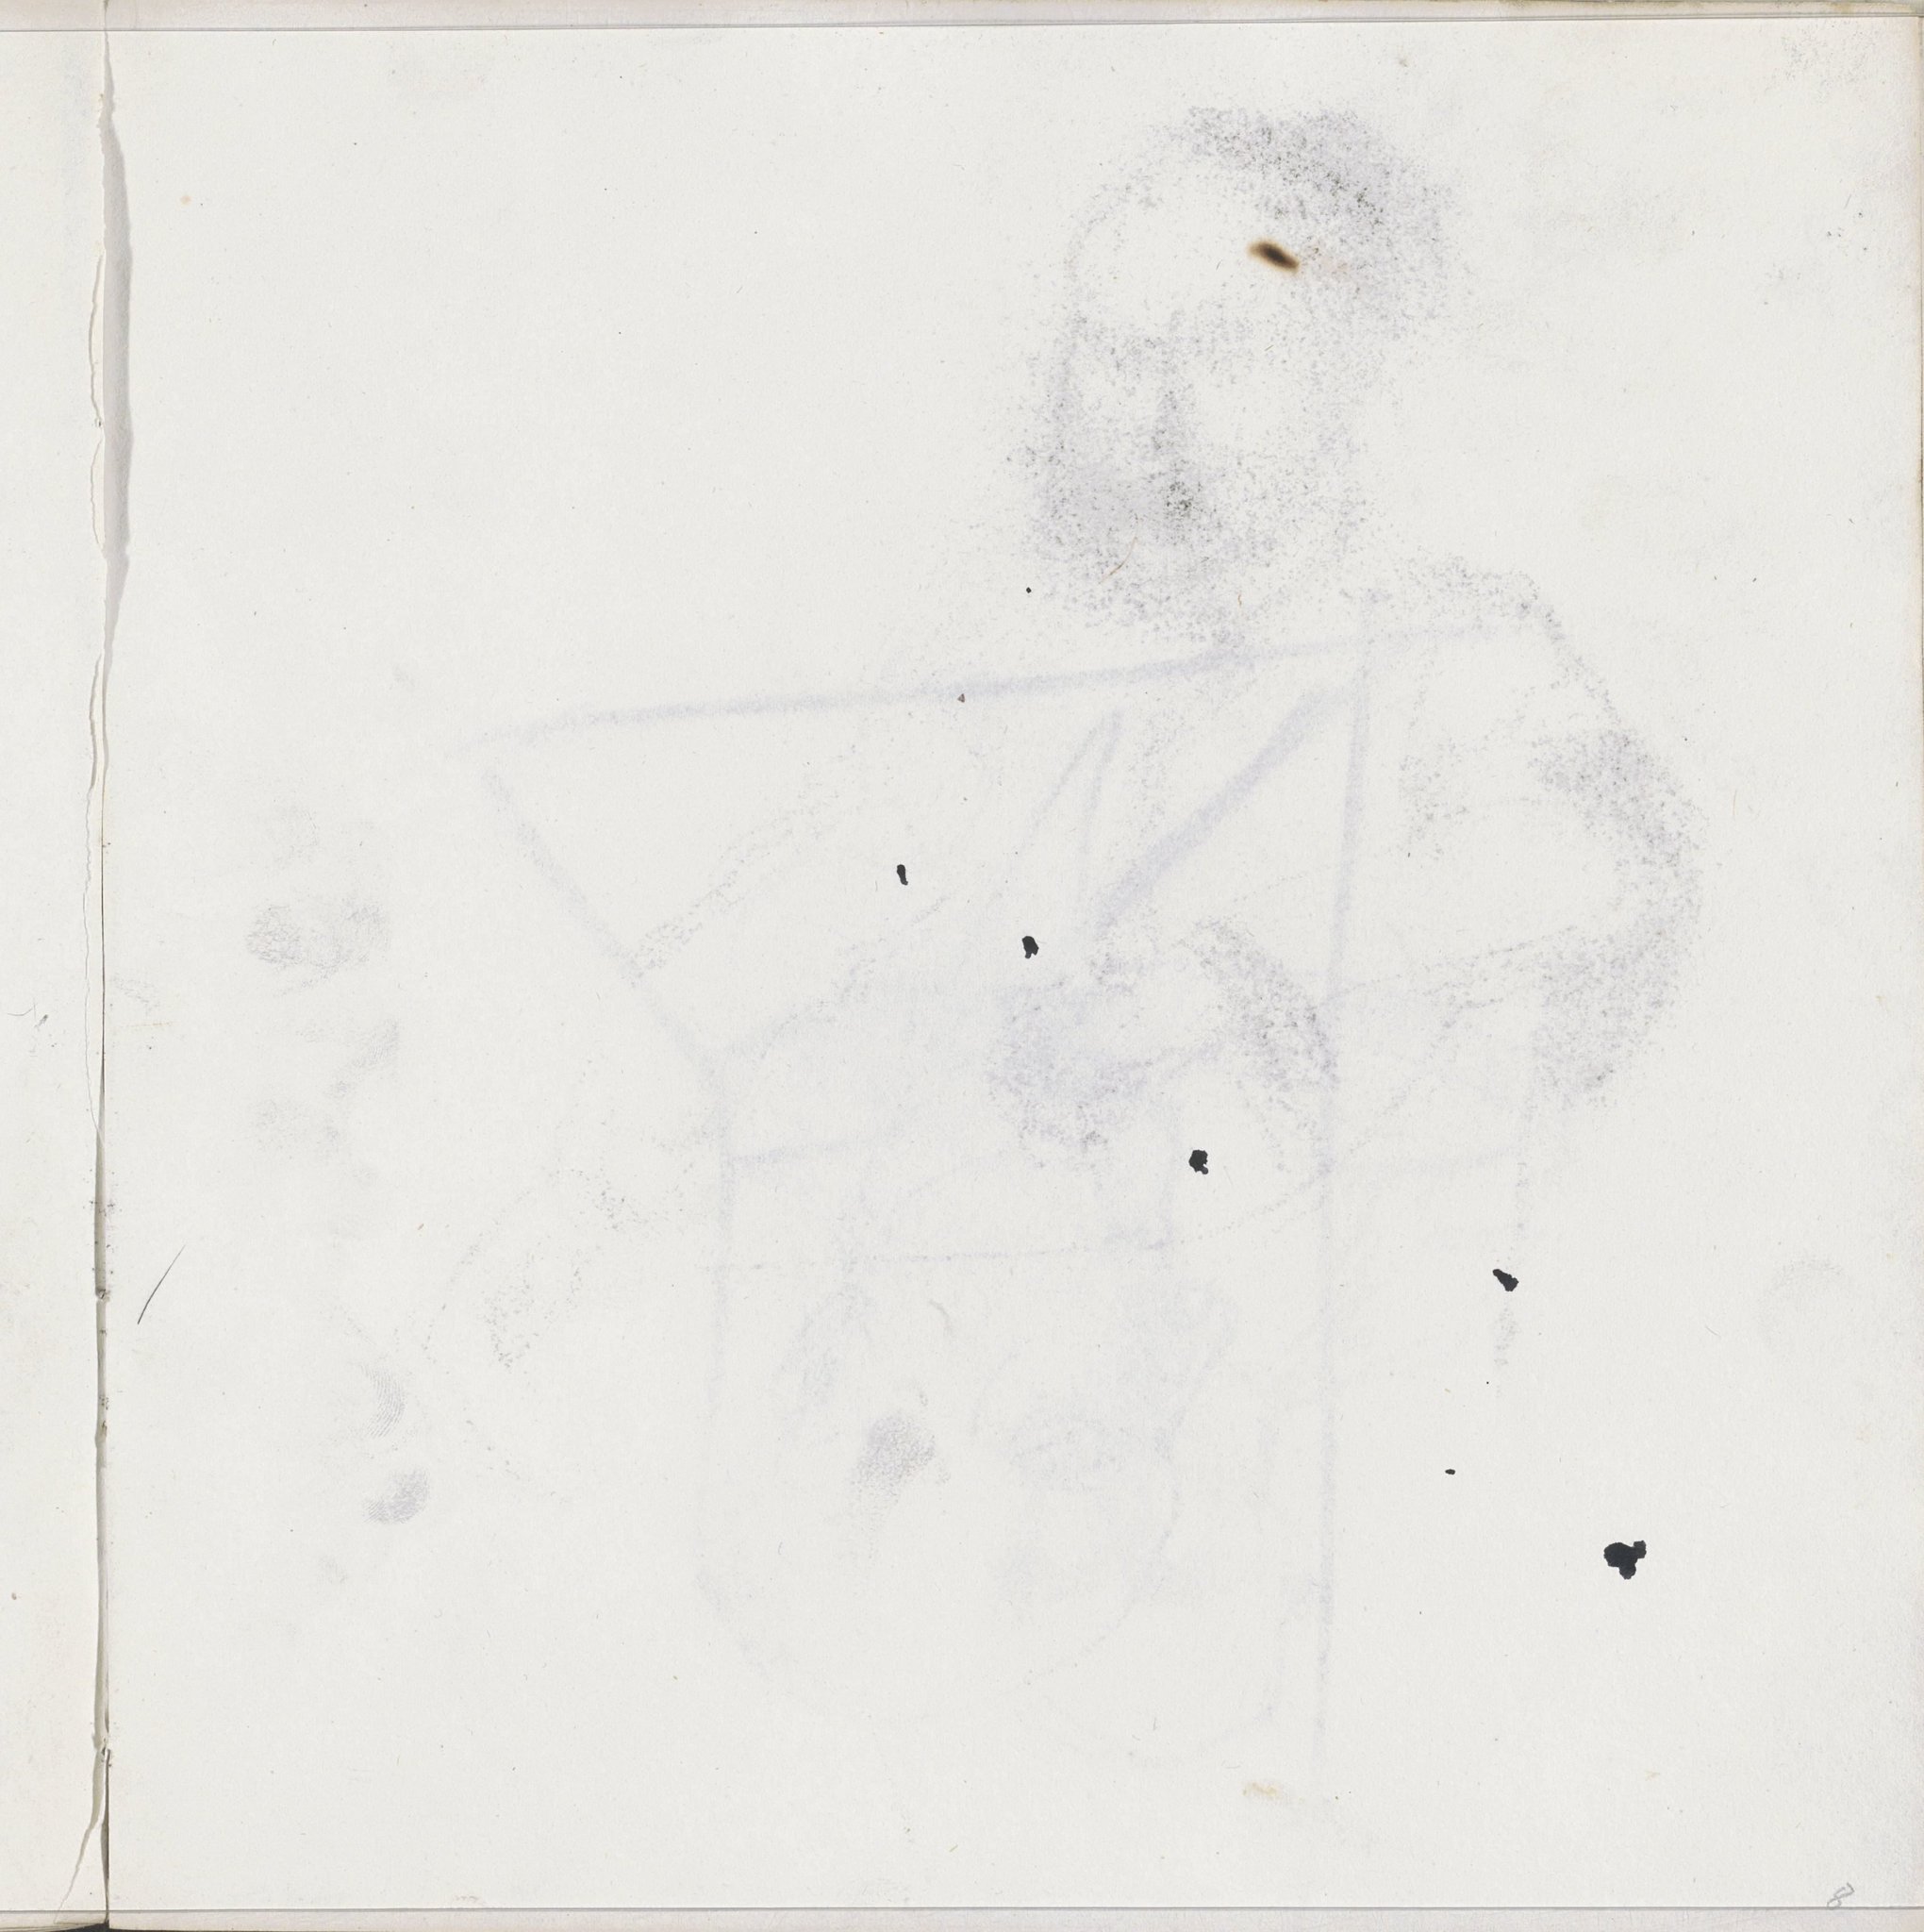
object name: sketchbook leaf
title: Abklatsch van de krijttekening op blad 7 verso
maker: isaac israels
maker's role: draughtsman, painter, print maker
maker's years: 1865-1934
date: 1875-1934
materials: paper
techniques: printmaking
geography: the hague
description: Blad 8 recto uit schetsboek IX met 28 bladen.